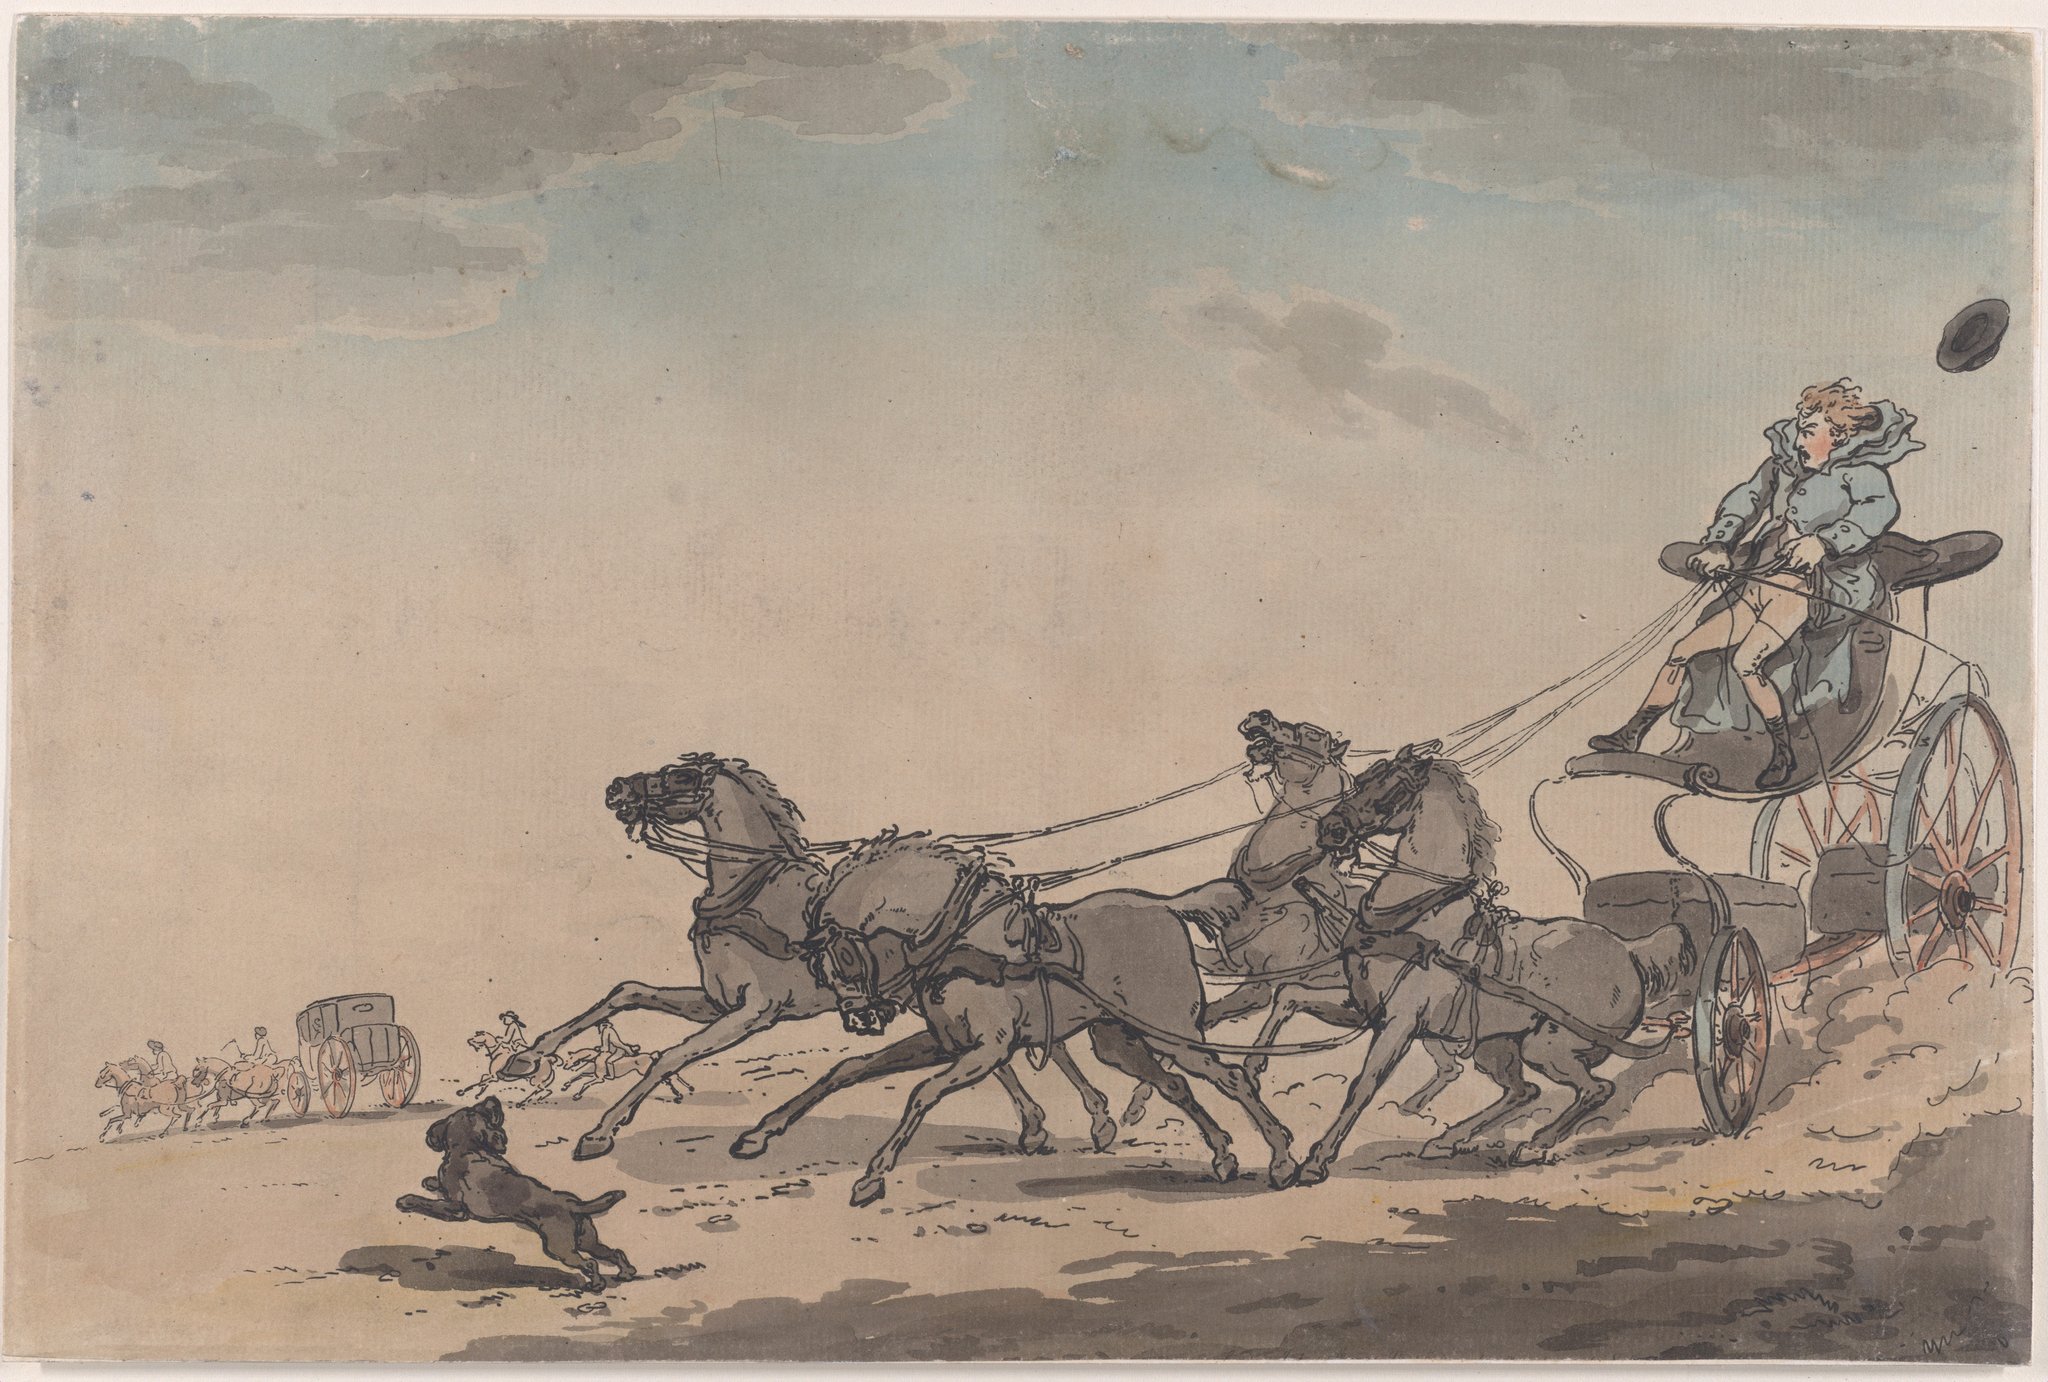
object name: print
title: A Four-in-Hand, or The Runaway Carriage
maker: thomas rowlandson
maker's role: artist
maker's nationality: british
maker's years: 1757-1827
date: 1791-1793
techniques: etching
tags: men,dogs,horses,carriages